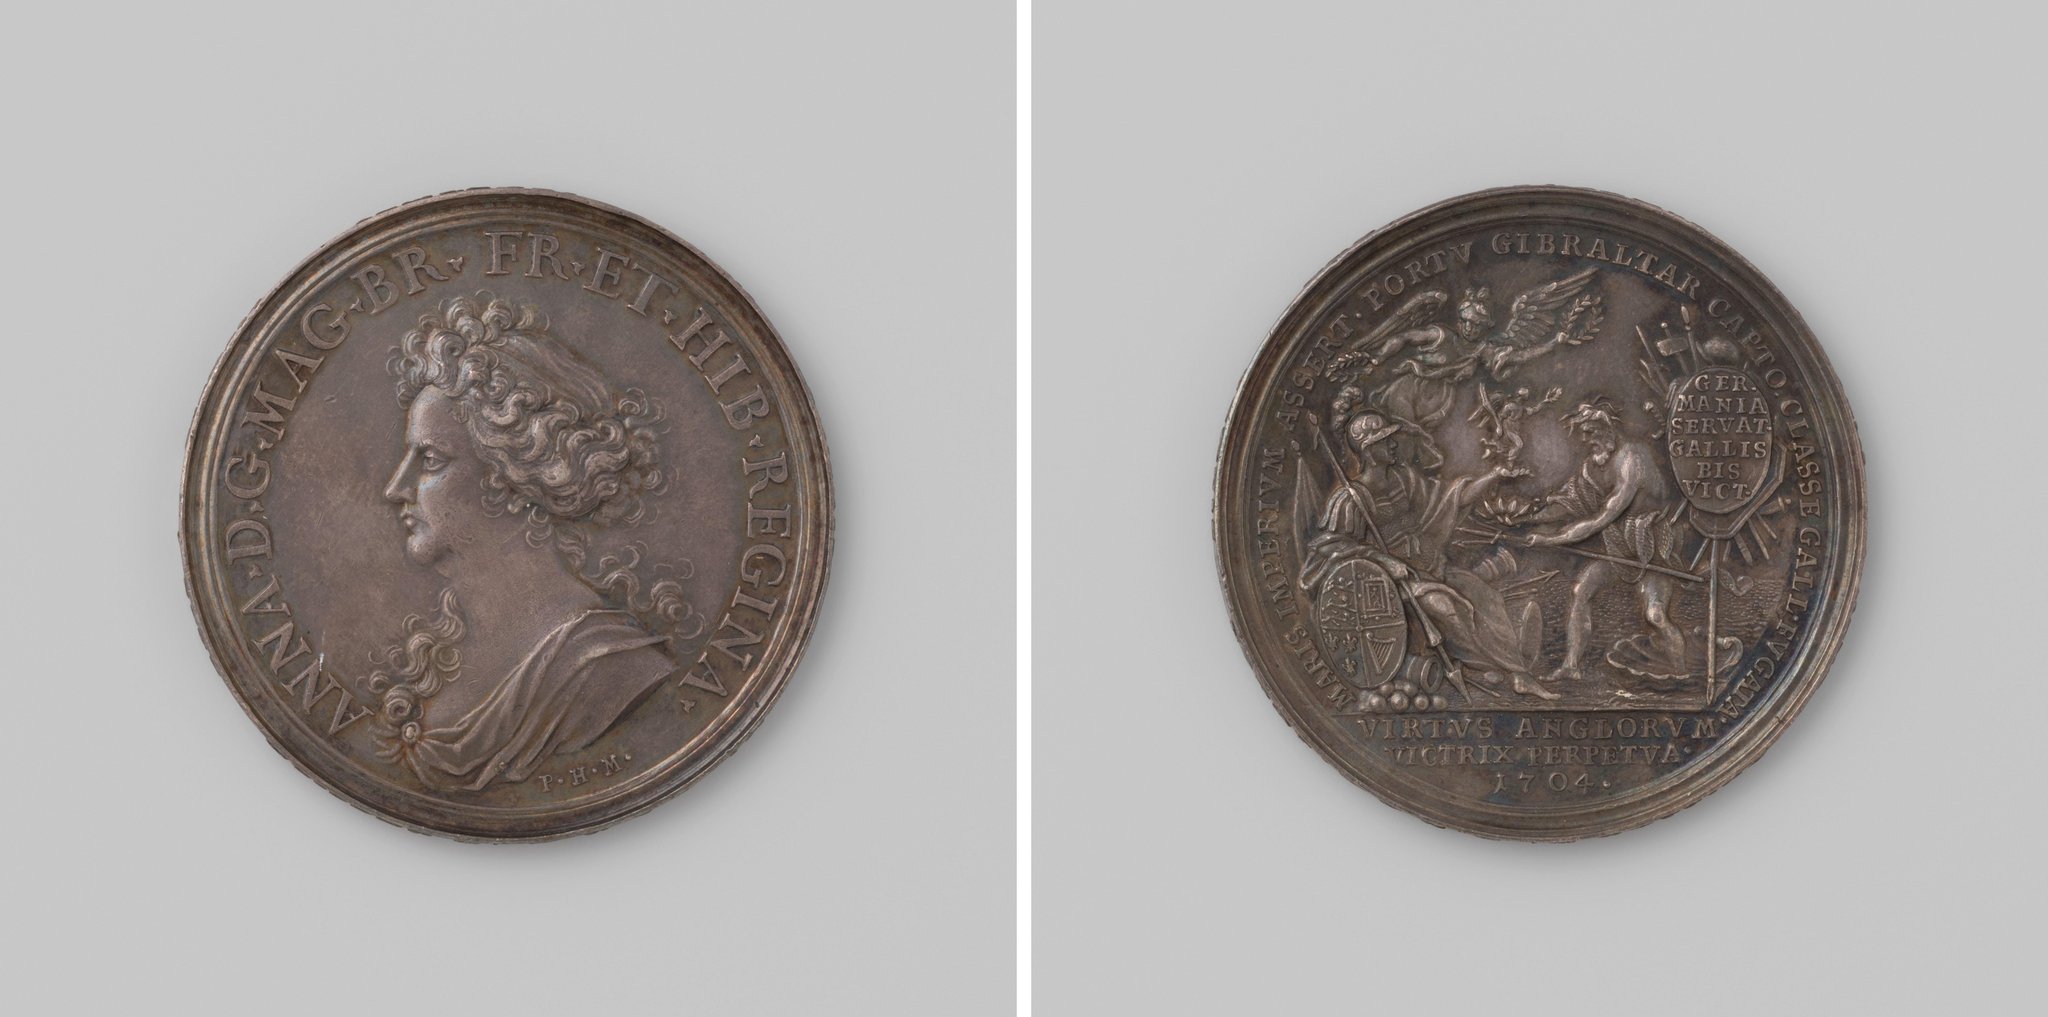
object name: history medal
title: Overwinningen van de Engelsen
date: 1704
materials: silver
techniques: striking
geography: nuremberg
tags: london, anna stuart (koningin van engeland en schotland), great britain, spain